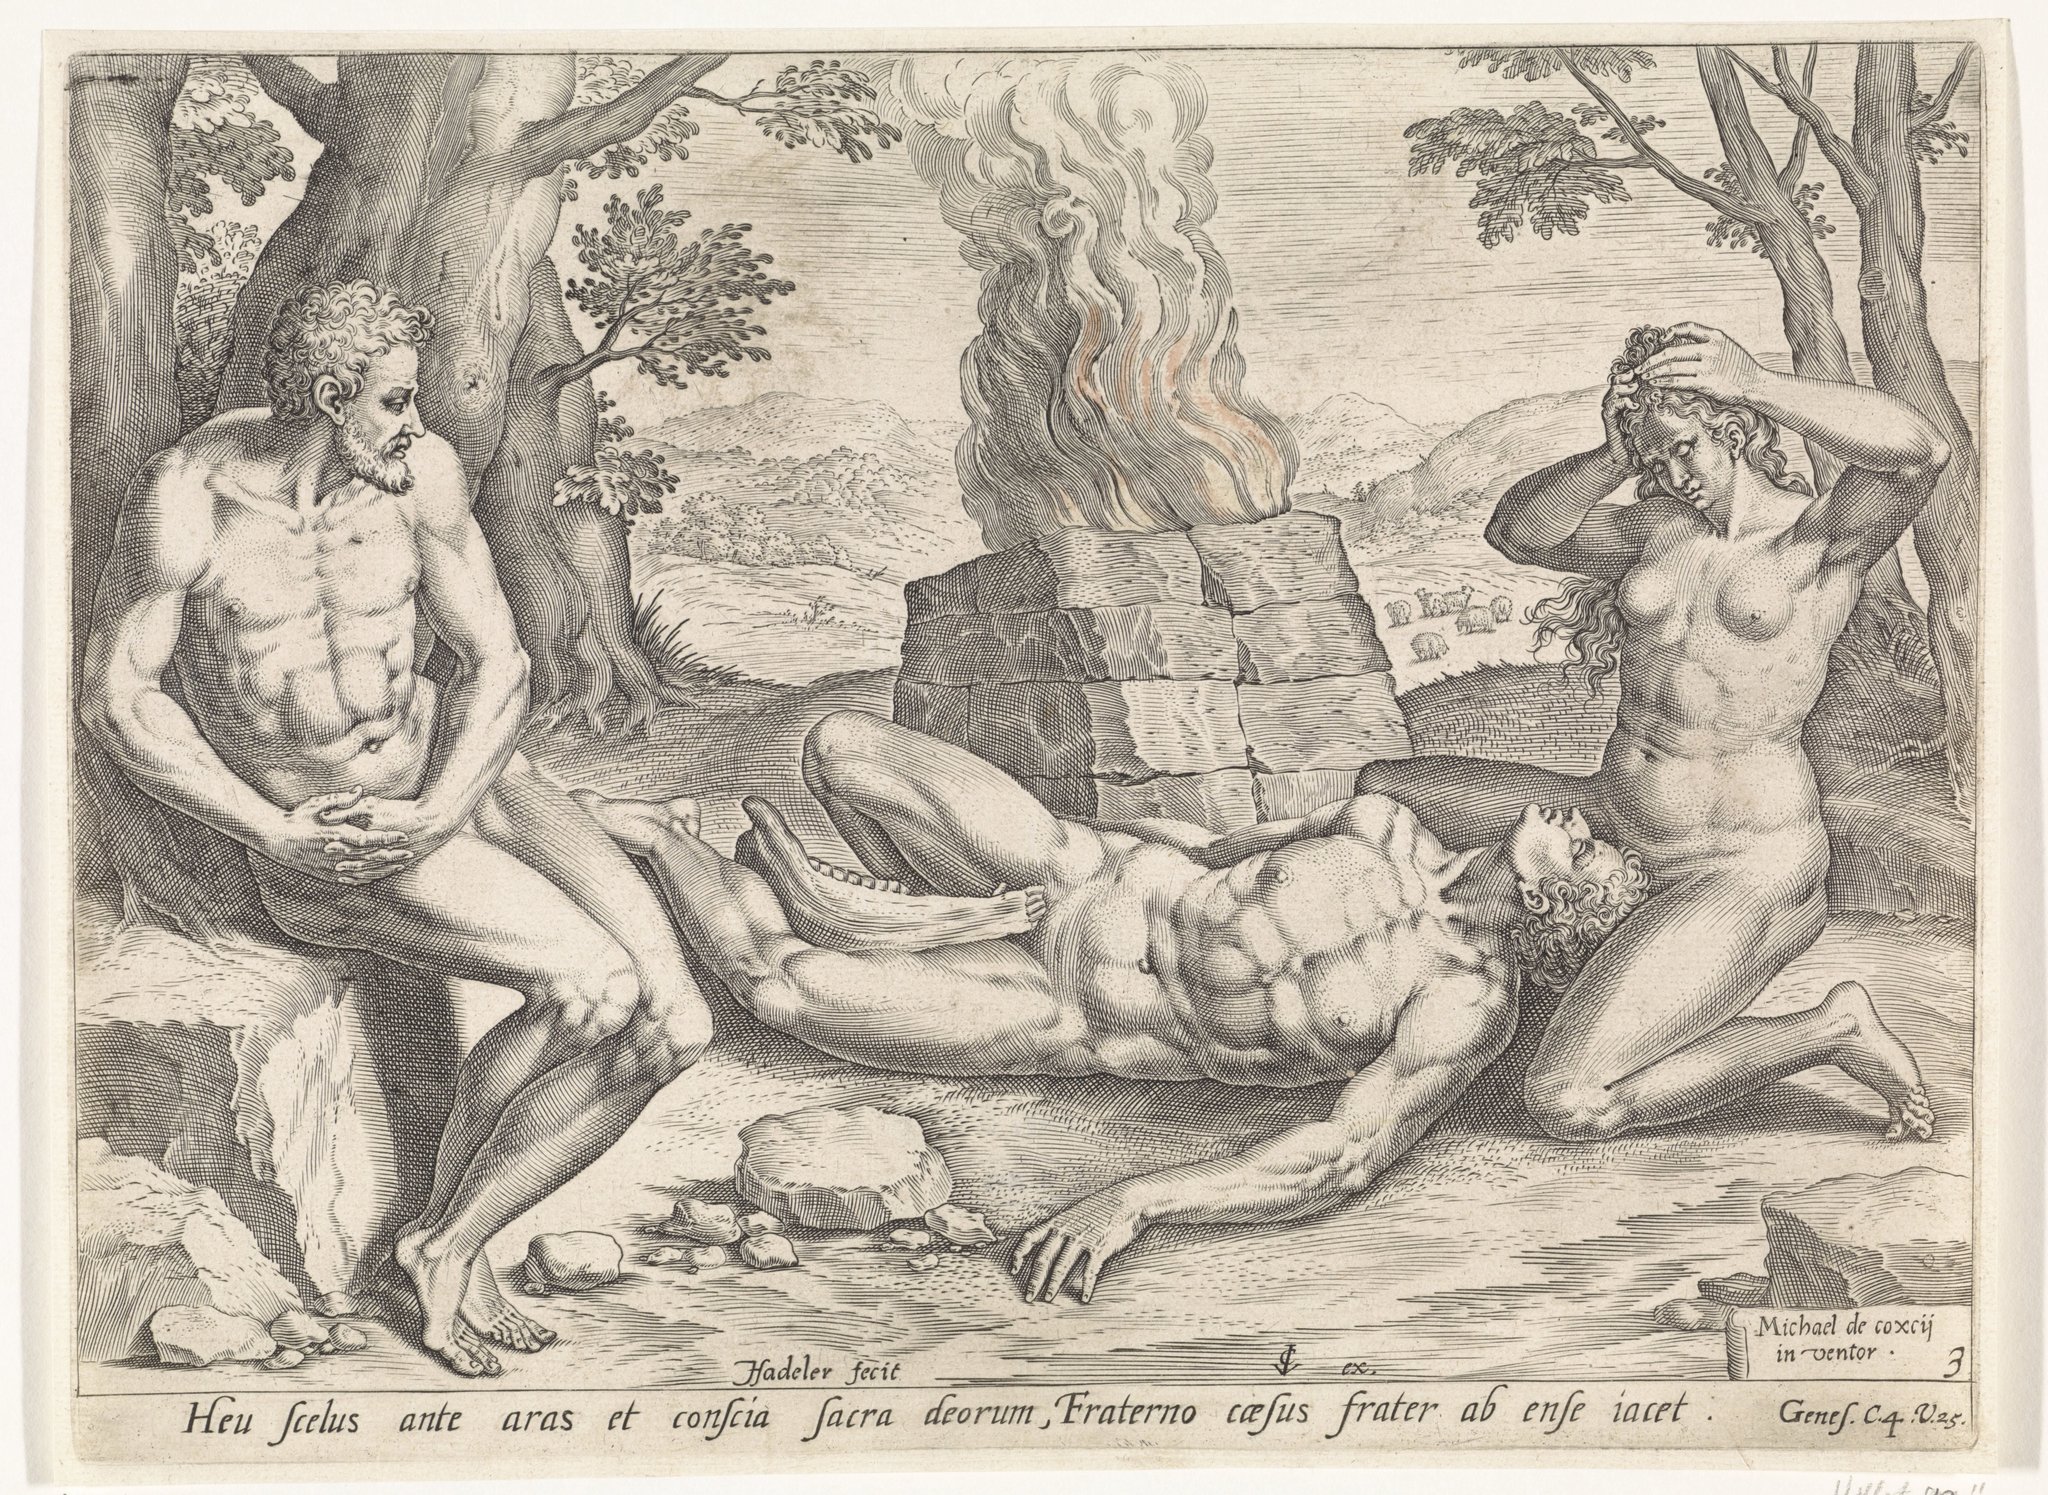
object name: print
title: Eva treurt om de dood om Abel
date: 1576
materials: paper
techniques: engraving, hand coloring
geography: amsterdam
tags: adam and eve discover the dead body of abel and grieve over it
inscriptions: collector's mark: Lugt 2228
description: De ouders van Kaïn en Abel vinden het lijk van hun zoon bij de offerplaats. Eva zit op haar knieën voor het lijk van Abel. Ze treurt om zijn dood. Links zit Adam op een steen. De prent heeft een Latijns onderschrift.